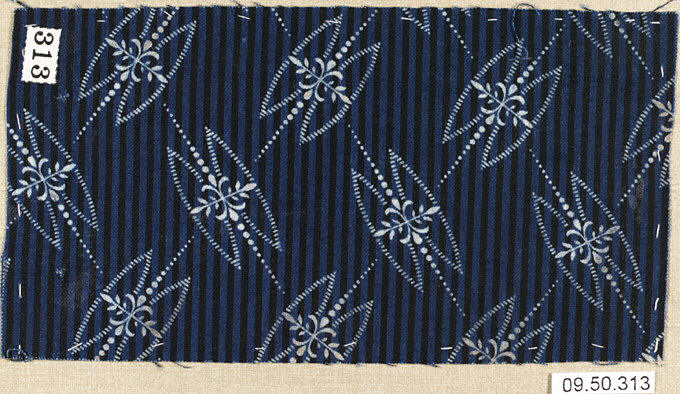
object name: piece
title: Piece (one of 116)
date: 1801-1900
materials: cotton